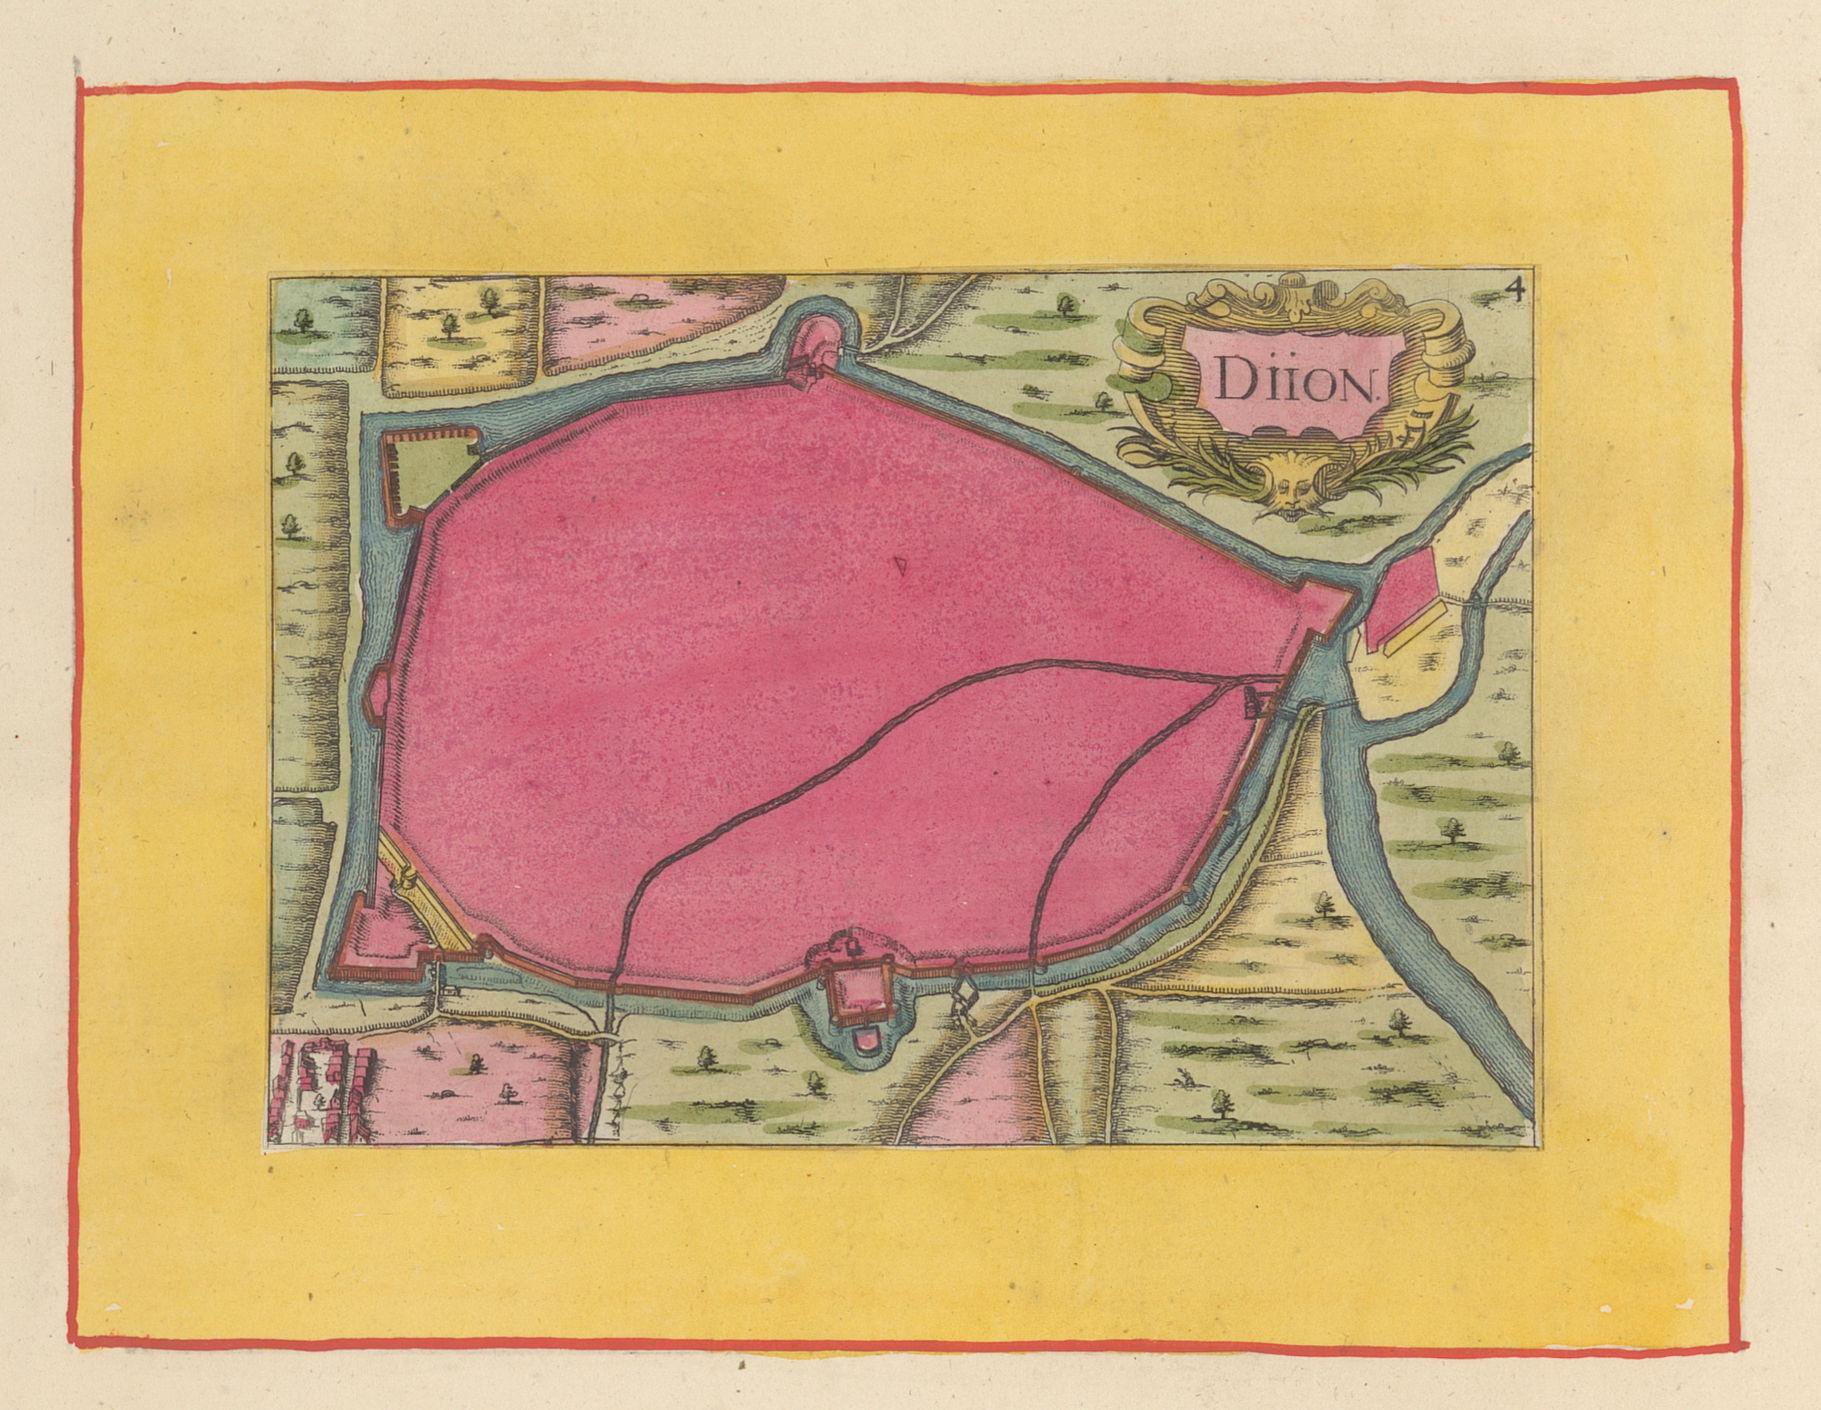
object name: album leaf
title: Vestingplattegrond van Dijon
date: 1638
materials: paper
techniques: engraving, hand coloring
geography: amsterdam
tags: maps of cities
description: Prent uit: Tassin, Christophe. Les plans et profils de toutes les principales villes et lieux considérables de France (...). Parijs: Michel van Lochom, 1638, kaart 4 uit het deel 'Bourgongne'.